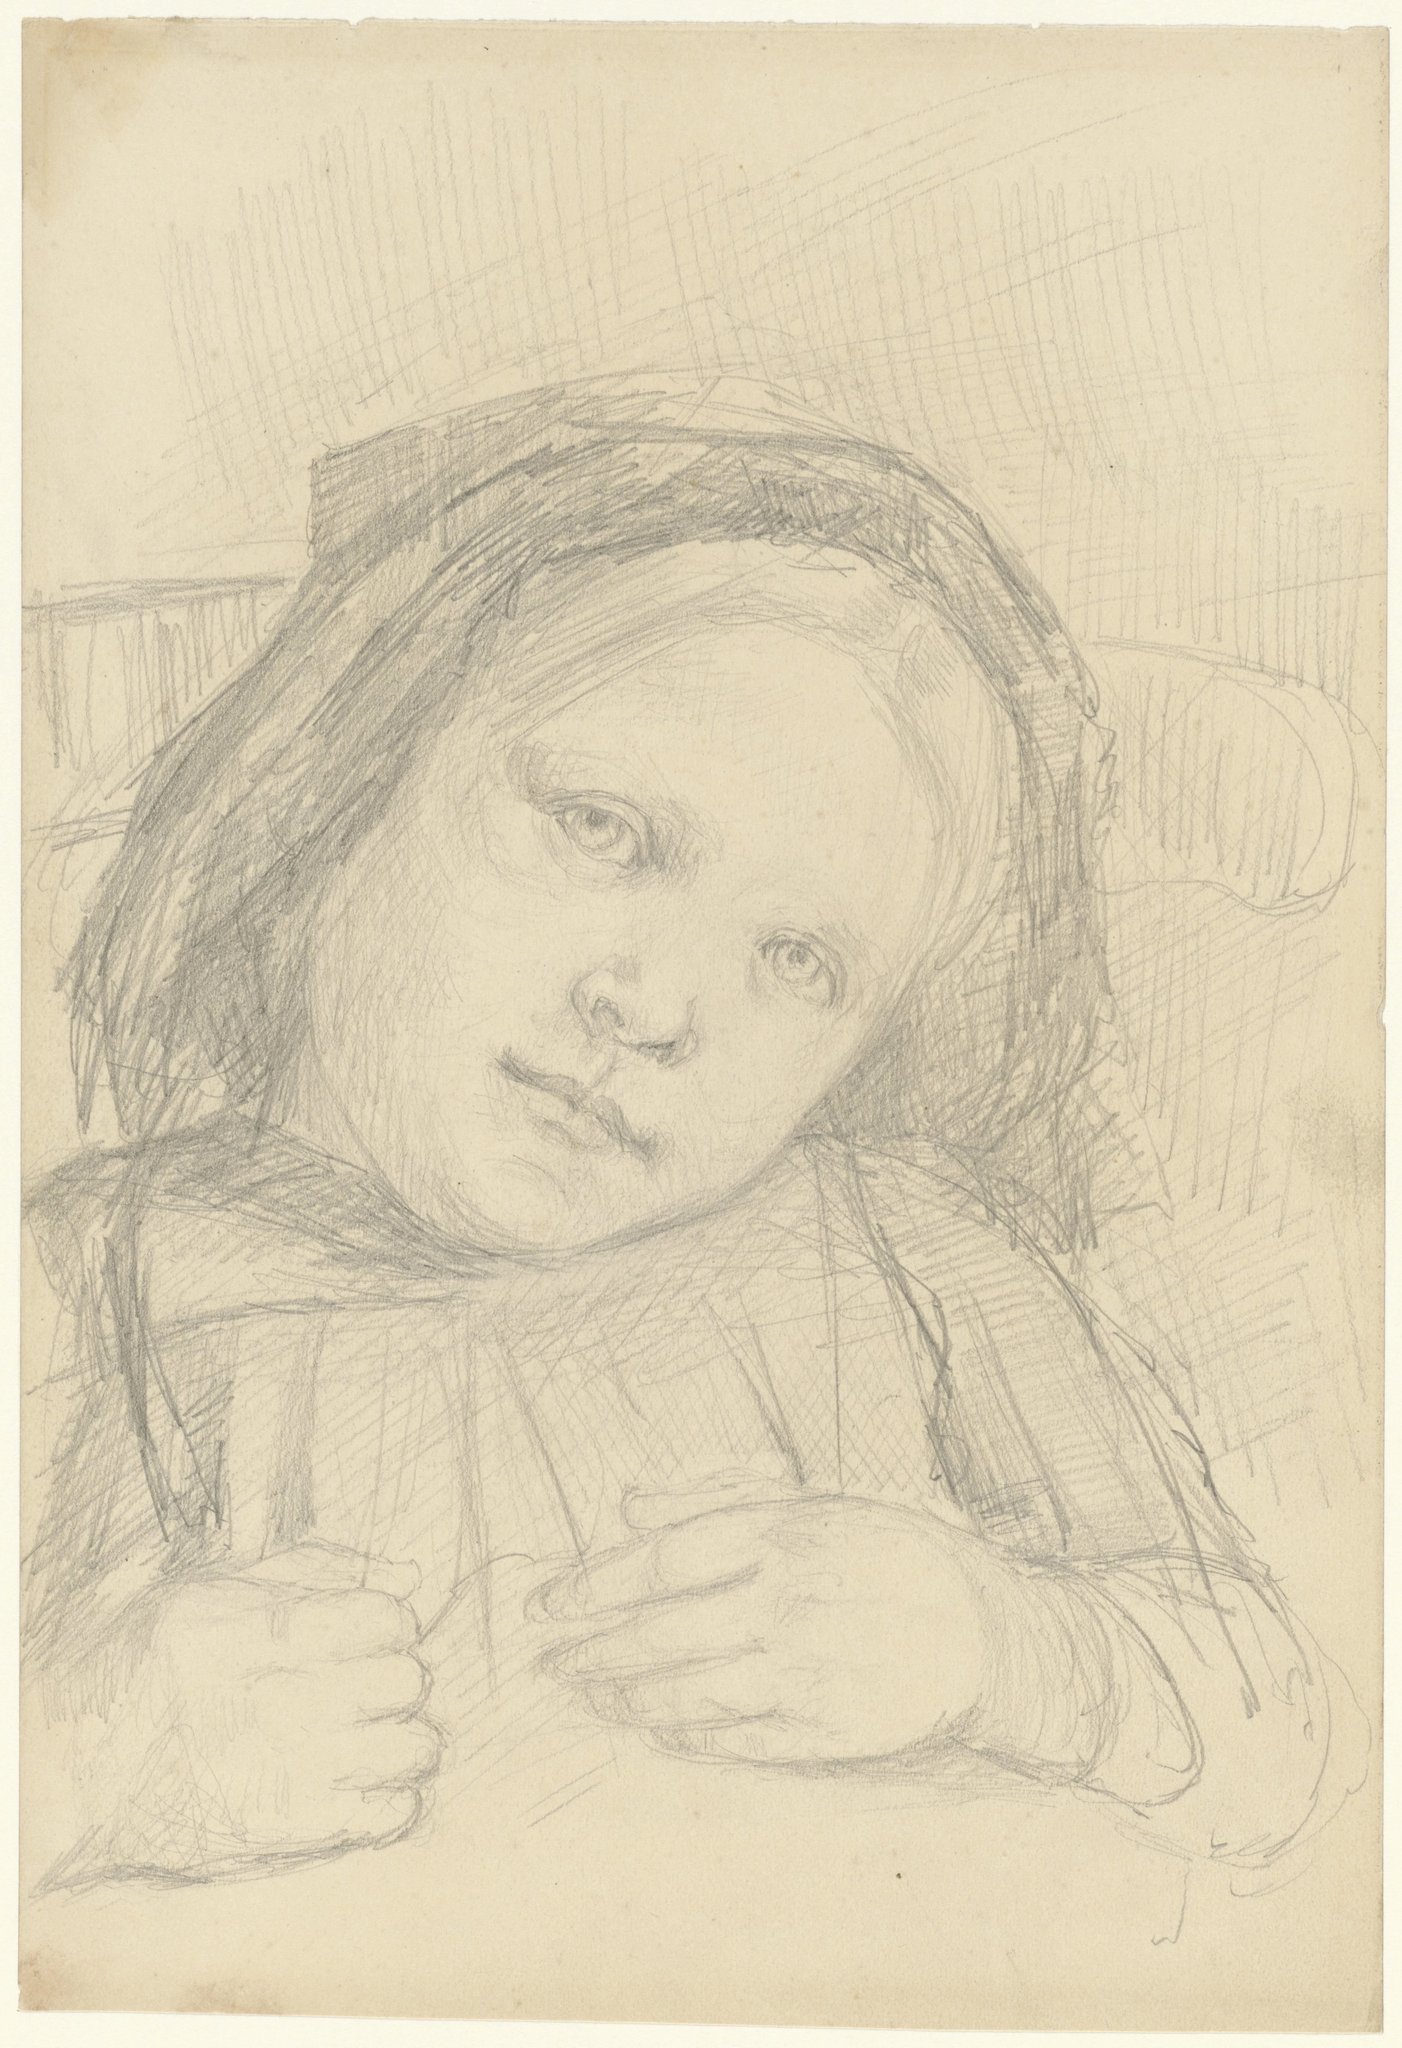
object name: drawing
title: Meisje met de handen voor de borst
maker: jozef israëls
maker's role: draughtsman, painter, print maker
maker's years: 1824-1911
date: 1834-1911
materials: paper, pencil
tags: anonymous historical person portrayed alone